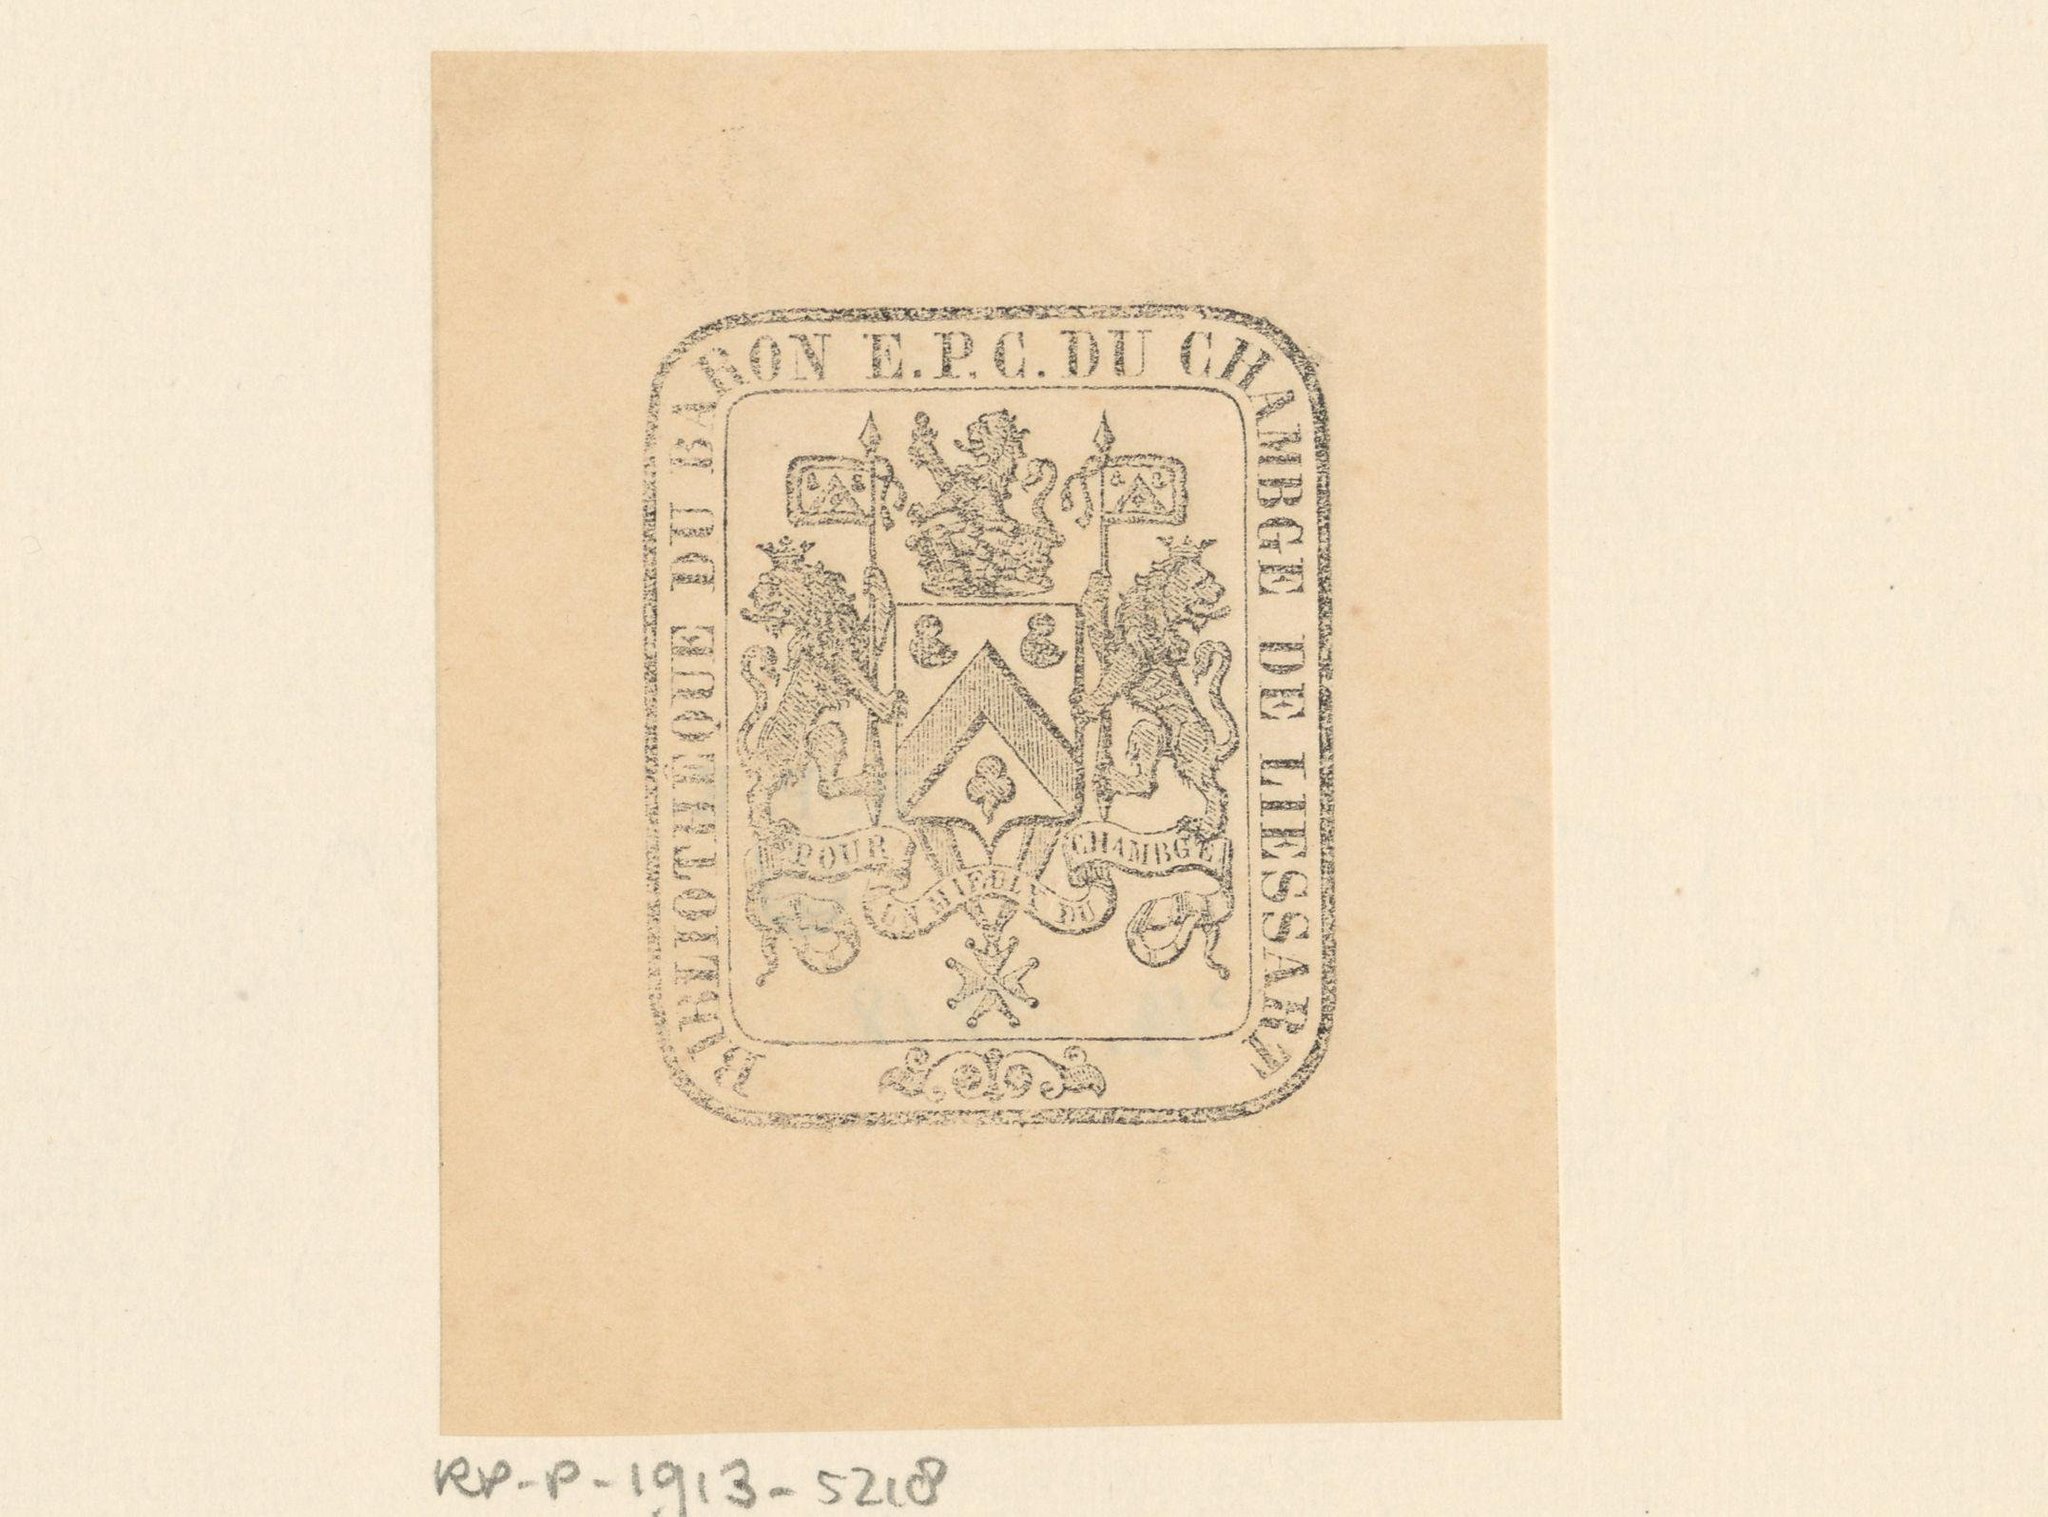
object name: bookplate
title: Bibliothèque du baron E.P.C. du Chambge de Liessart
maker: Anonymous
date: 1834-1913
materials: paper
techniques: relief print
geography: belgium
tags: beasts of prey, predatory animals: lion, armorial bearing, heraldry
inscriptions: collector's mark: Lugt 2233, collector's mark: Lugt 2760